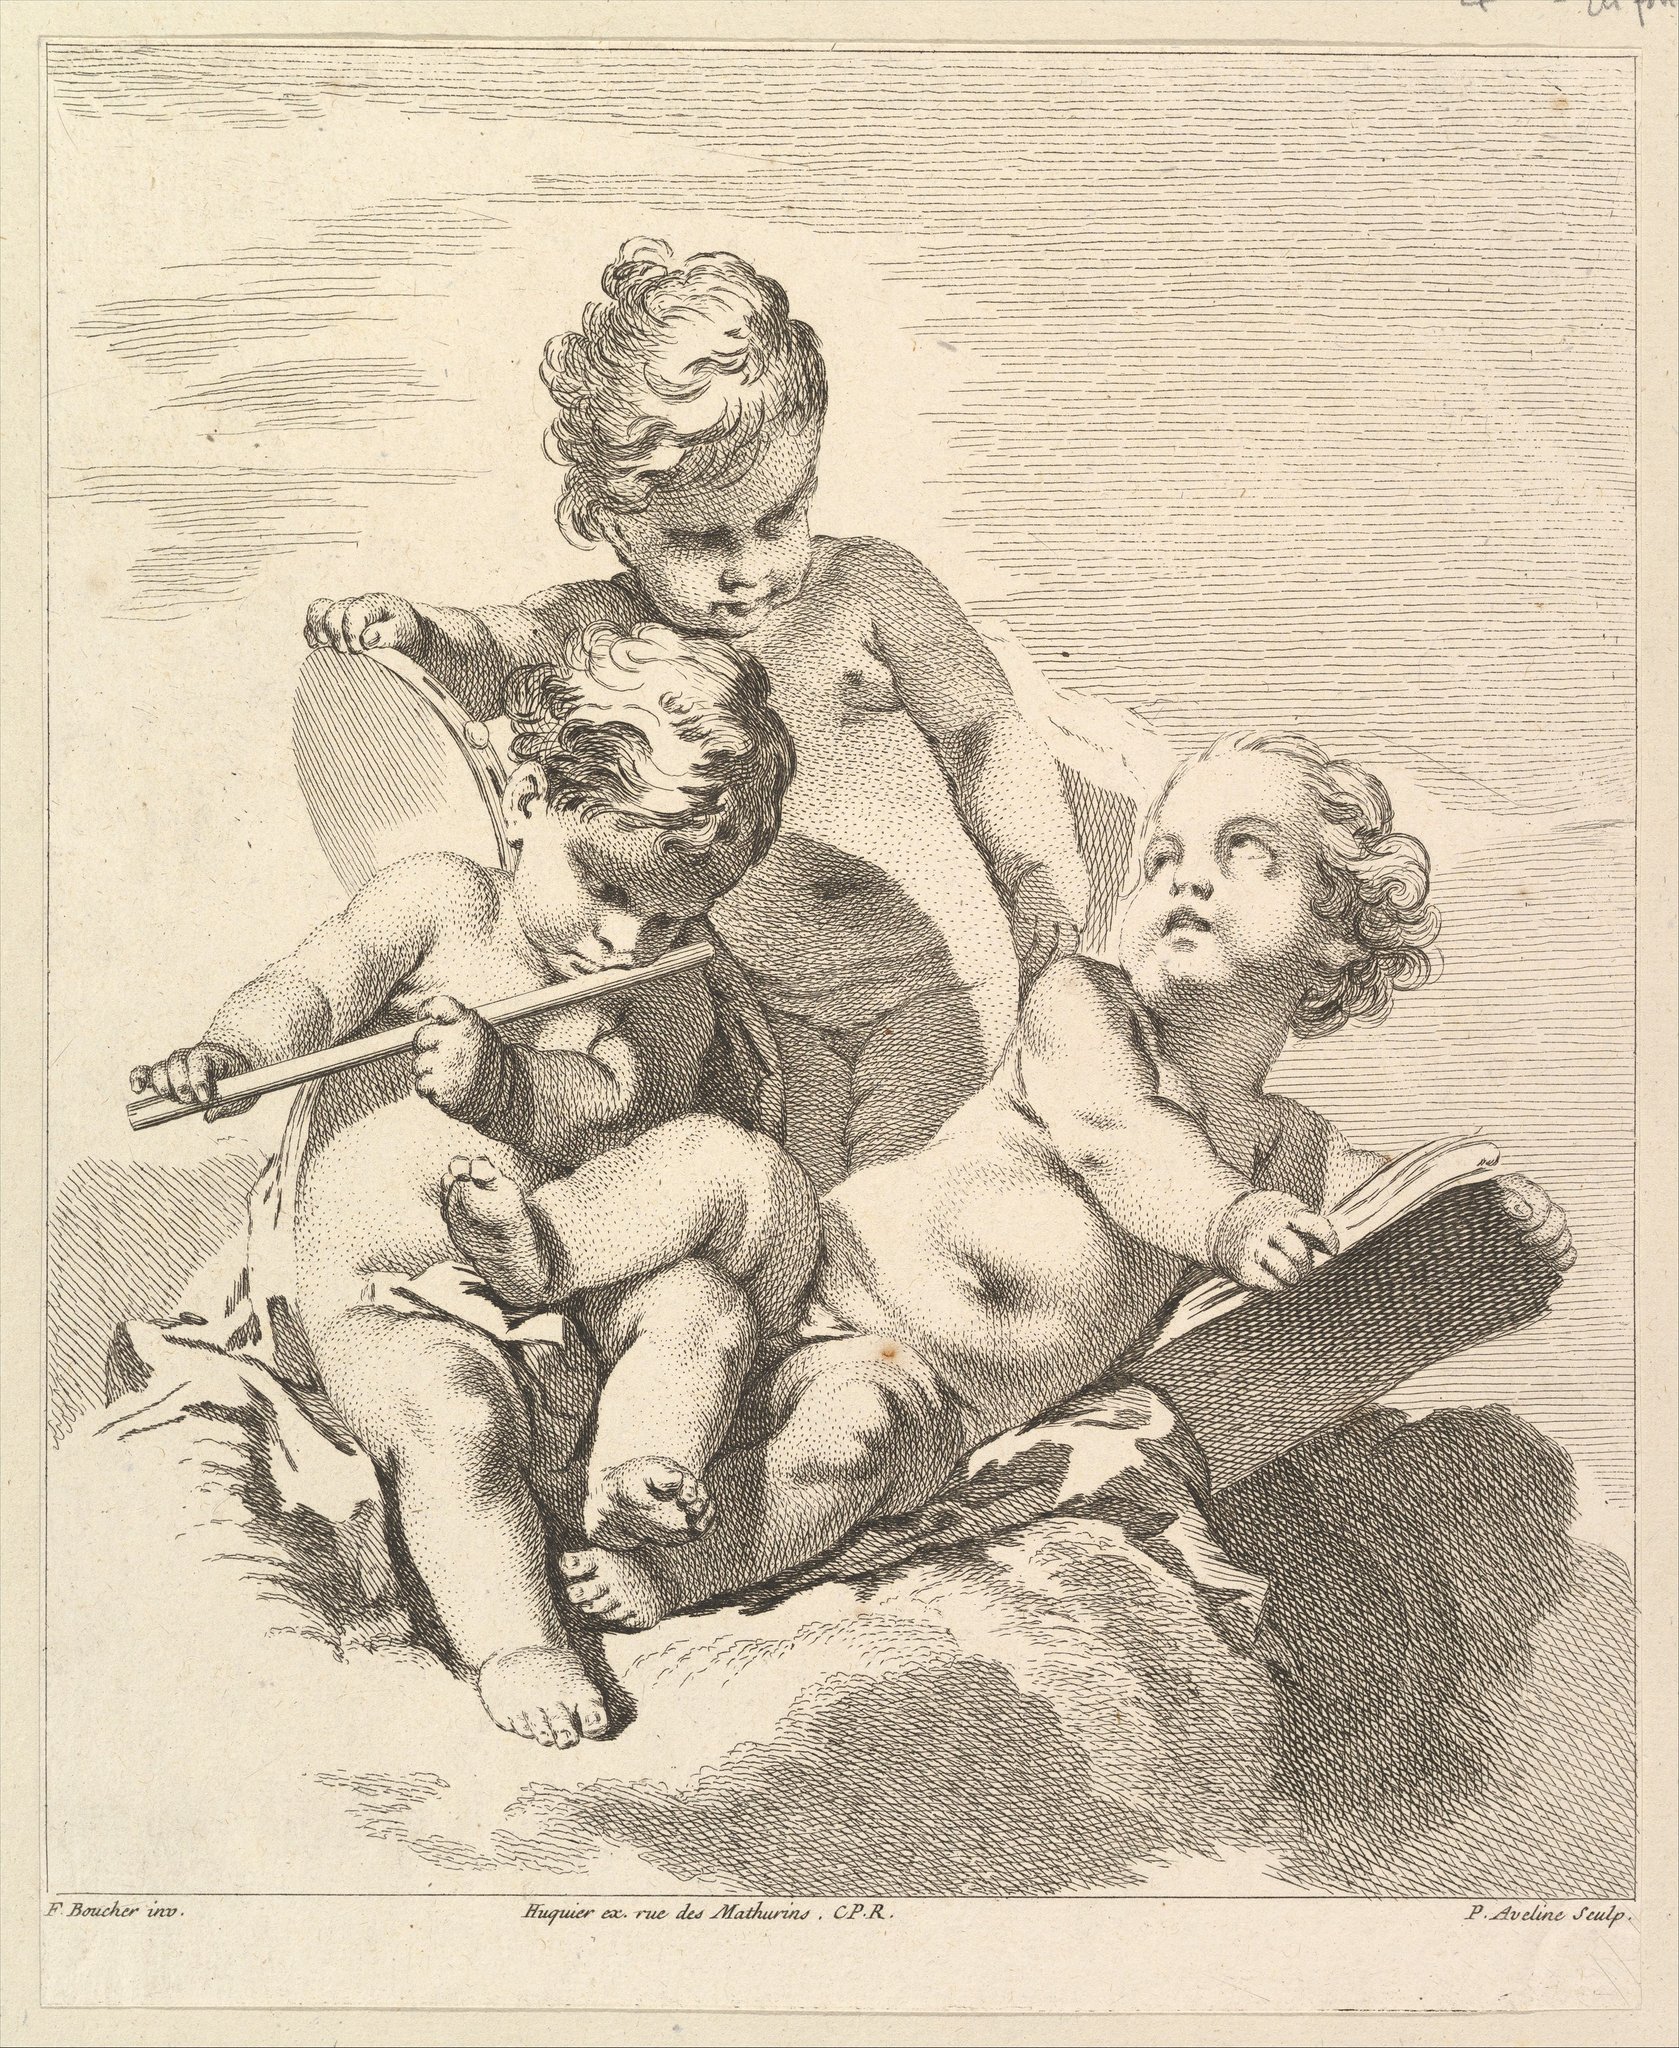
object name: print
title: Three Loves with Musical Instruments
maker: pierre alexandre aveline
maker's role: artist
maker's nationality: french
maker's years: 1702-1760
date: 1727-1760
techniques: engraving, etching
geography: france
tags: children,flutes